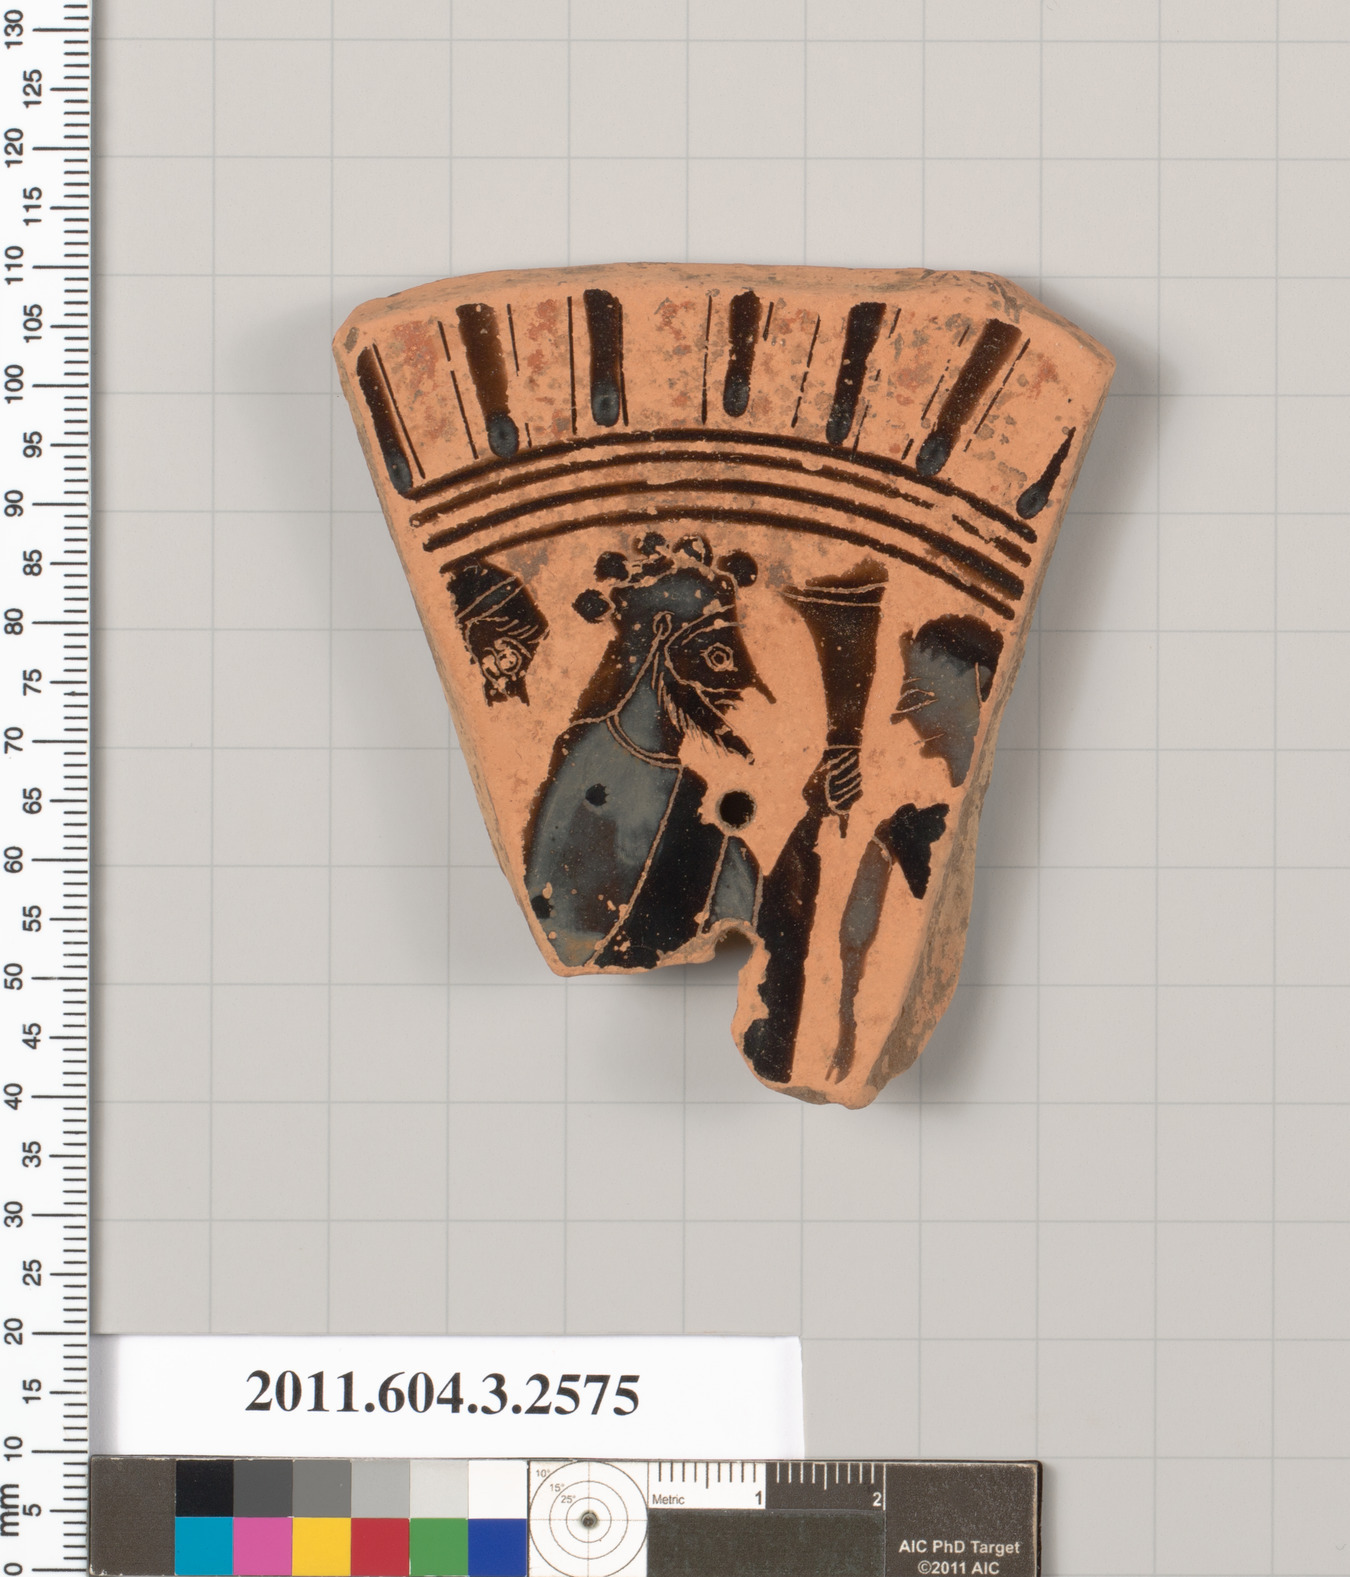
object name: kylix fragment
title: Terracotta fragment of a Little Master cup (drinking cup)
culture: greek, attic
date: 550-530 BCE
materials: terracotta